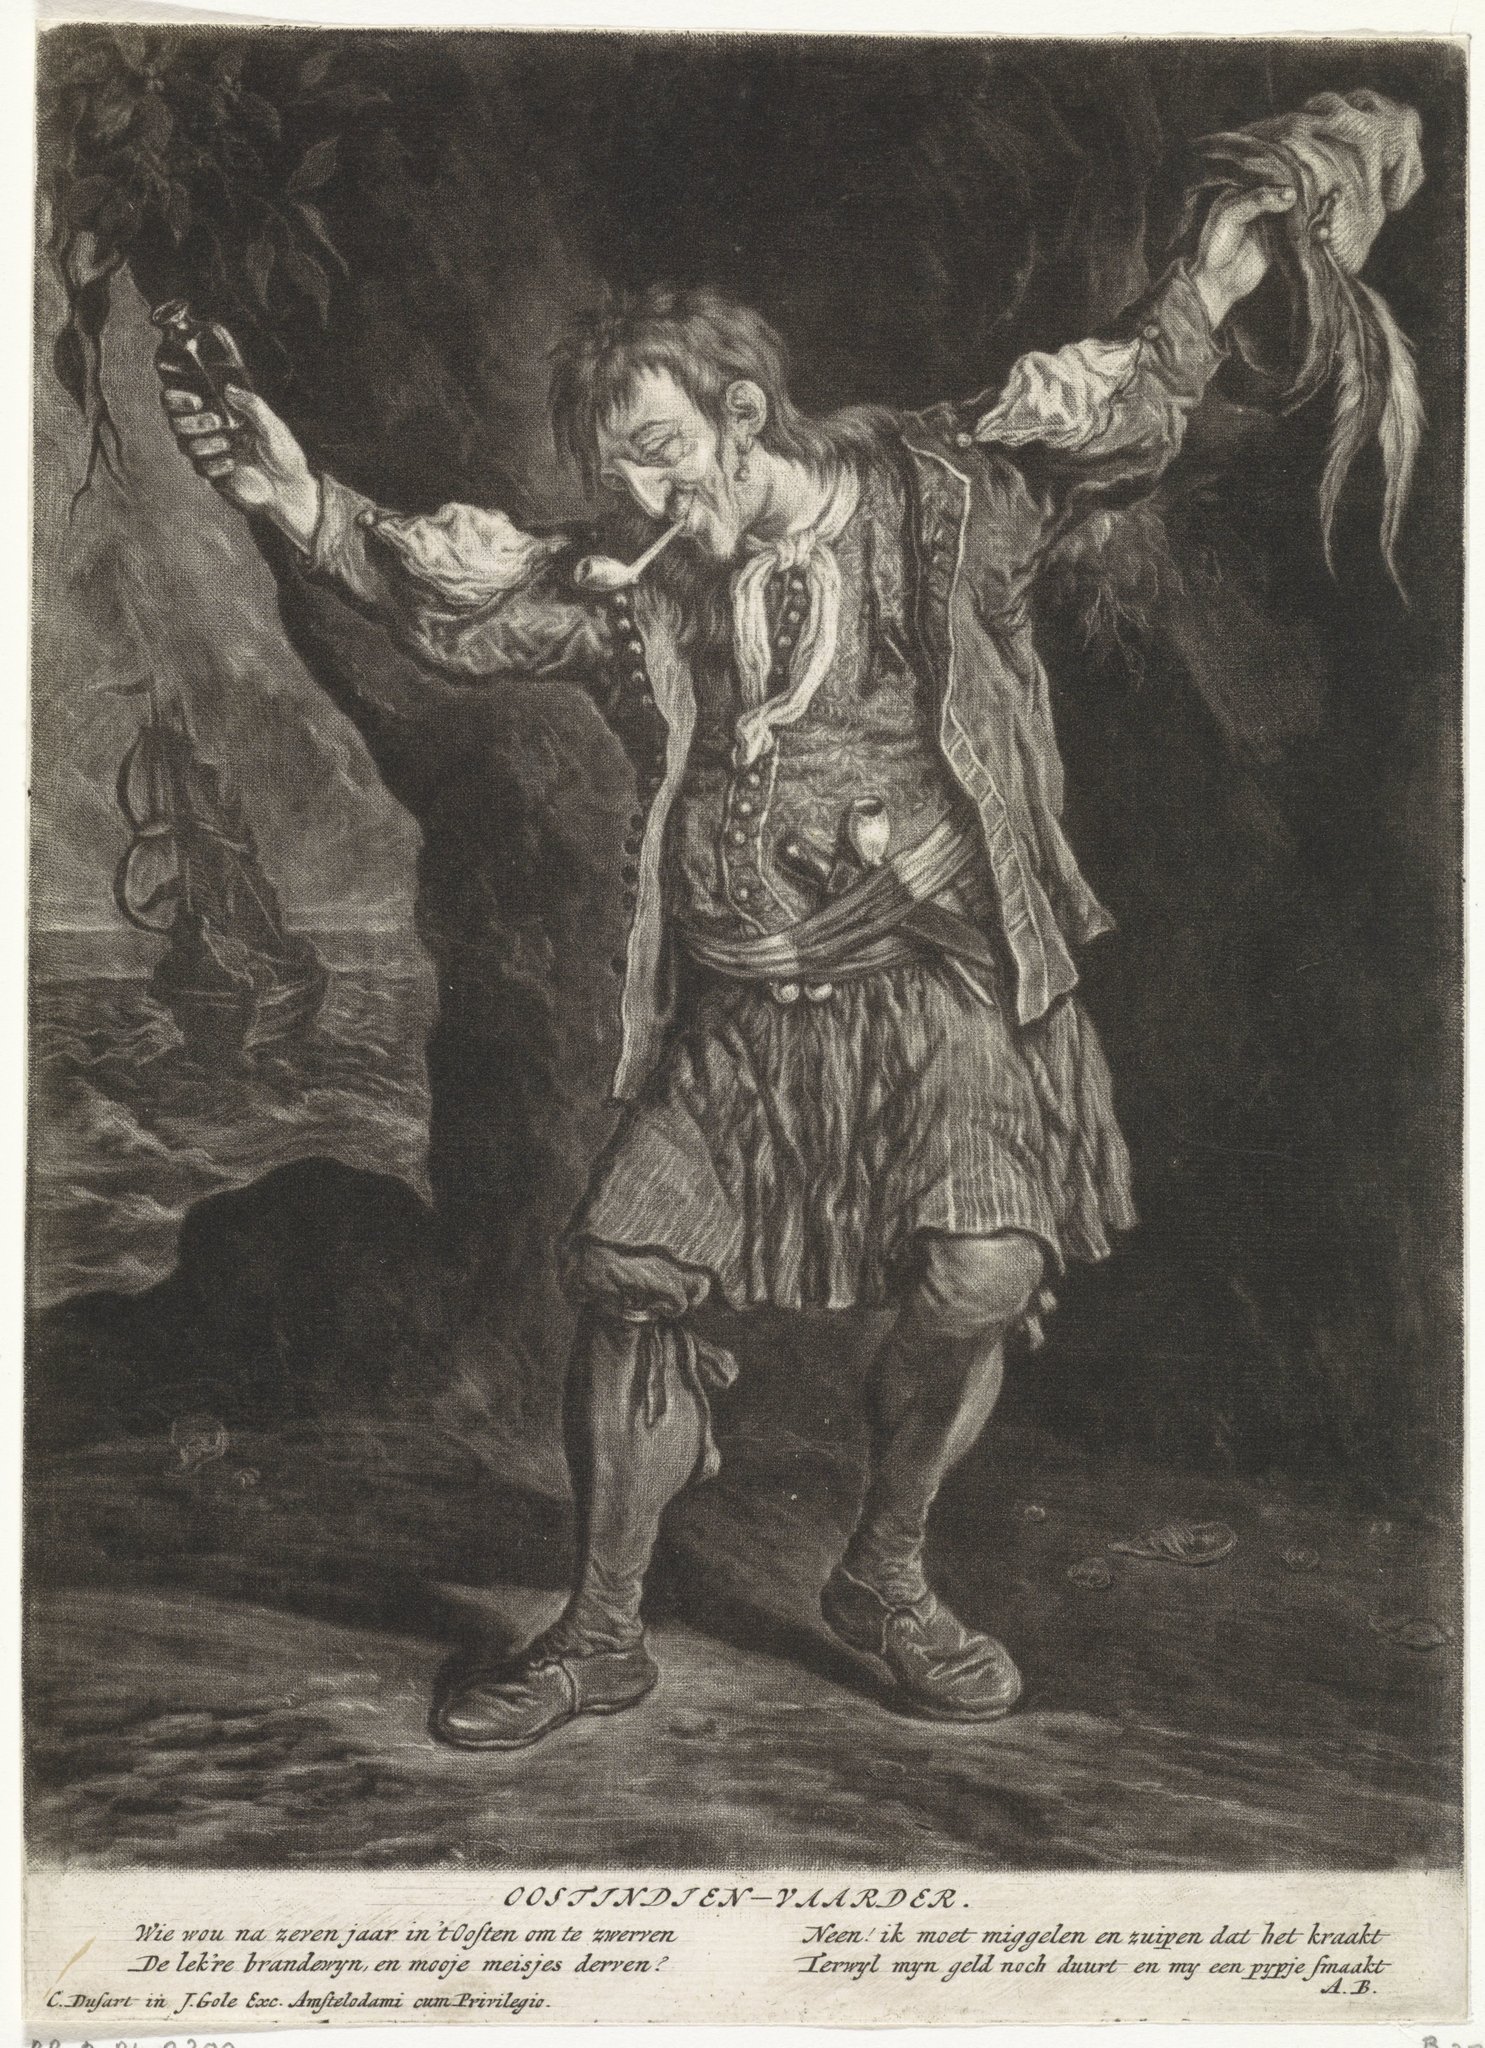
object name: print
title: Oostindien-vaarder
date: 1695-1704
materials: paper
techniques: engraving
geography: northern netherlands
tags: the hague, william iii (prince of orange and king of england, scotland, and ireland), drunkard, festivities on events of national importance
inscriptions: collector's mark: Lugt 240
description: Dronken matroos met een fles en een hoed in de hand. Op de achtergrond een schip op zee. Onder de voorstelling een Nederlandse titel en een vers van vier regels. De prent is onderdeel van een reeks van acht prenten vervaardigd naar aanleiding van de verovering van Namen door de geallieerden op 5 september 1695.